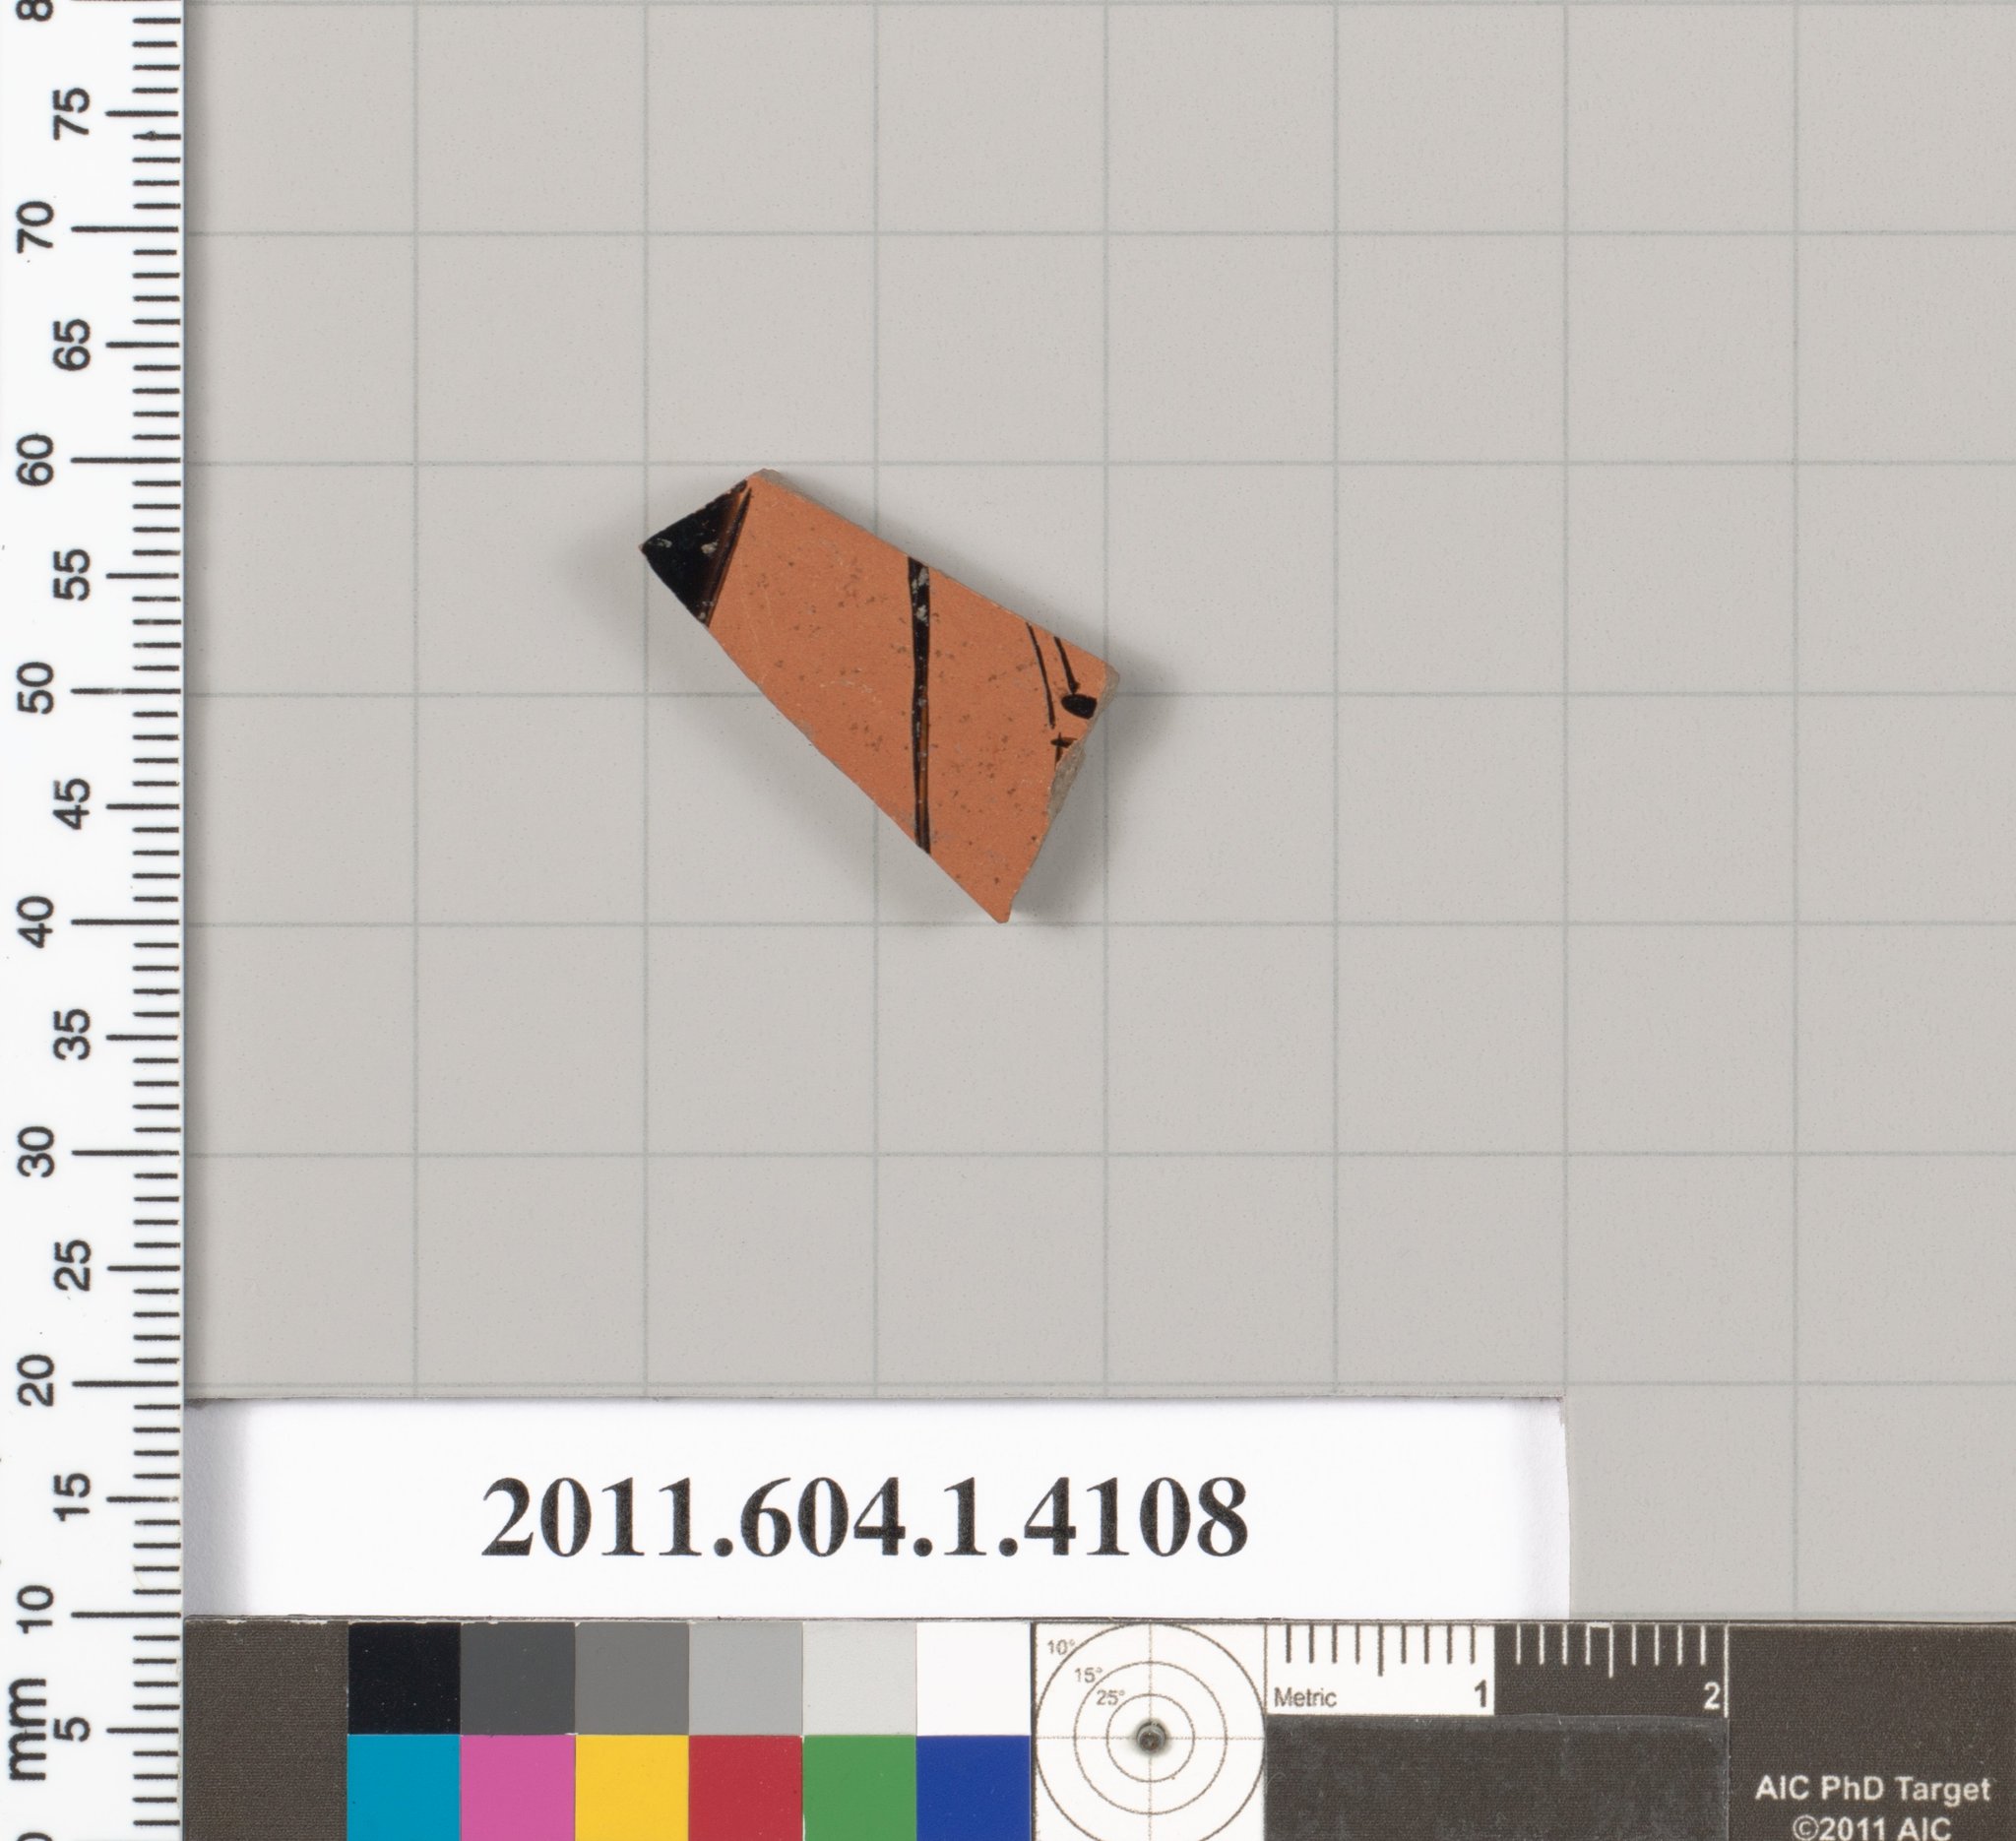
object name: kylix fragment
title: Terracotta fragment of a kylix (drinking cup)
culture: greek, attic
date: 520-490 BCE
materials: terracotta